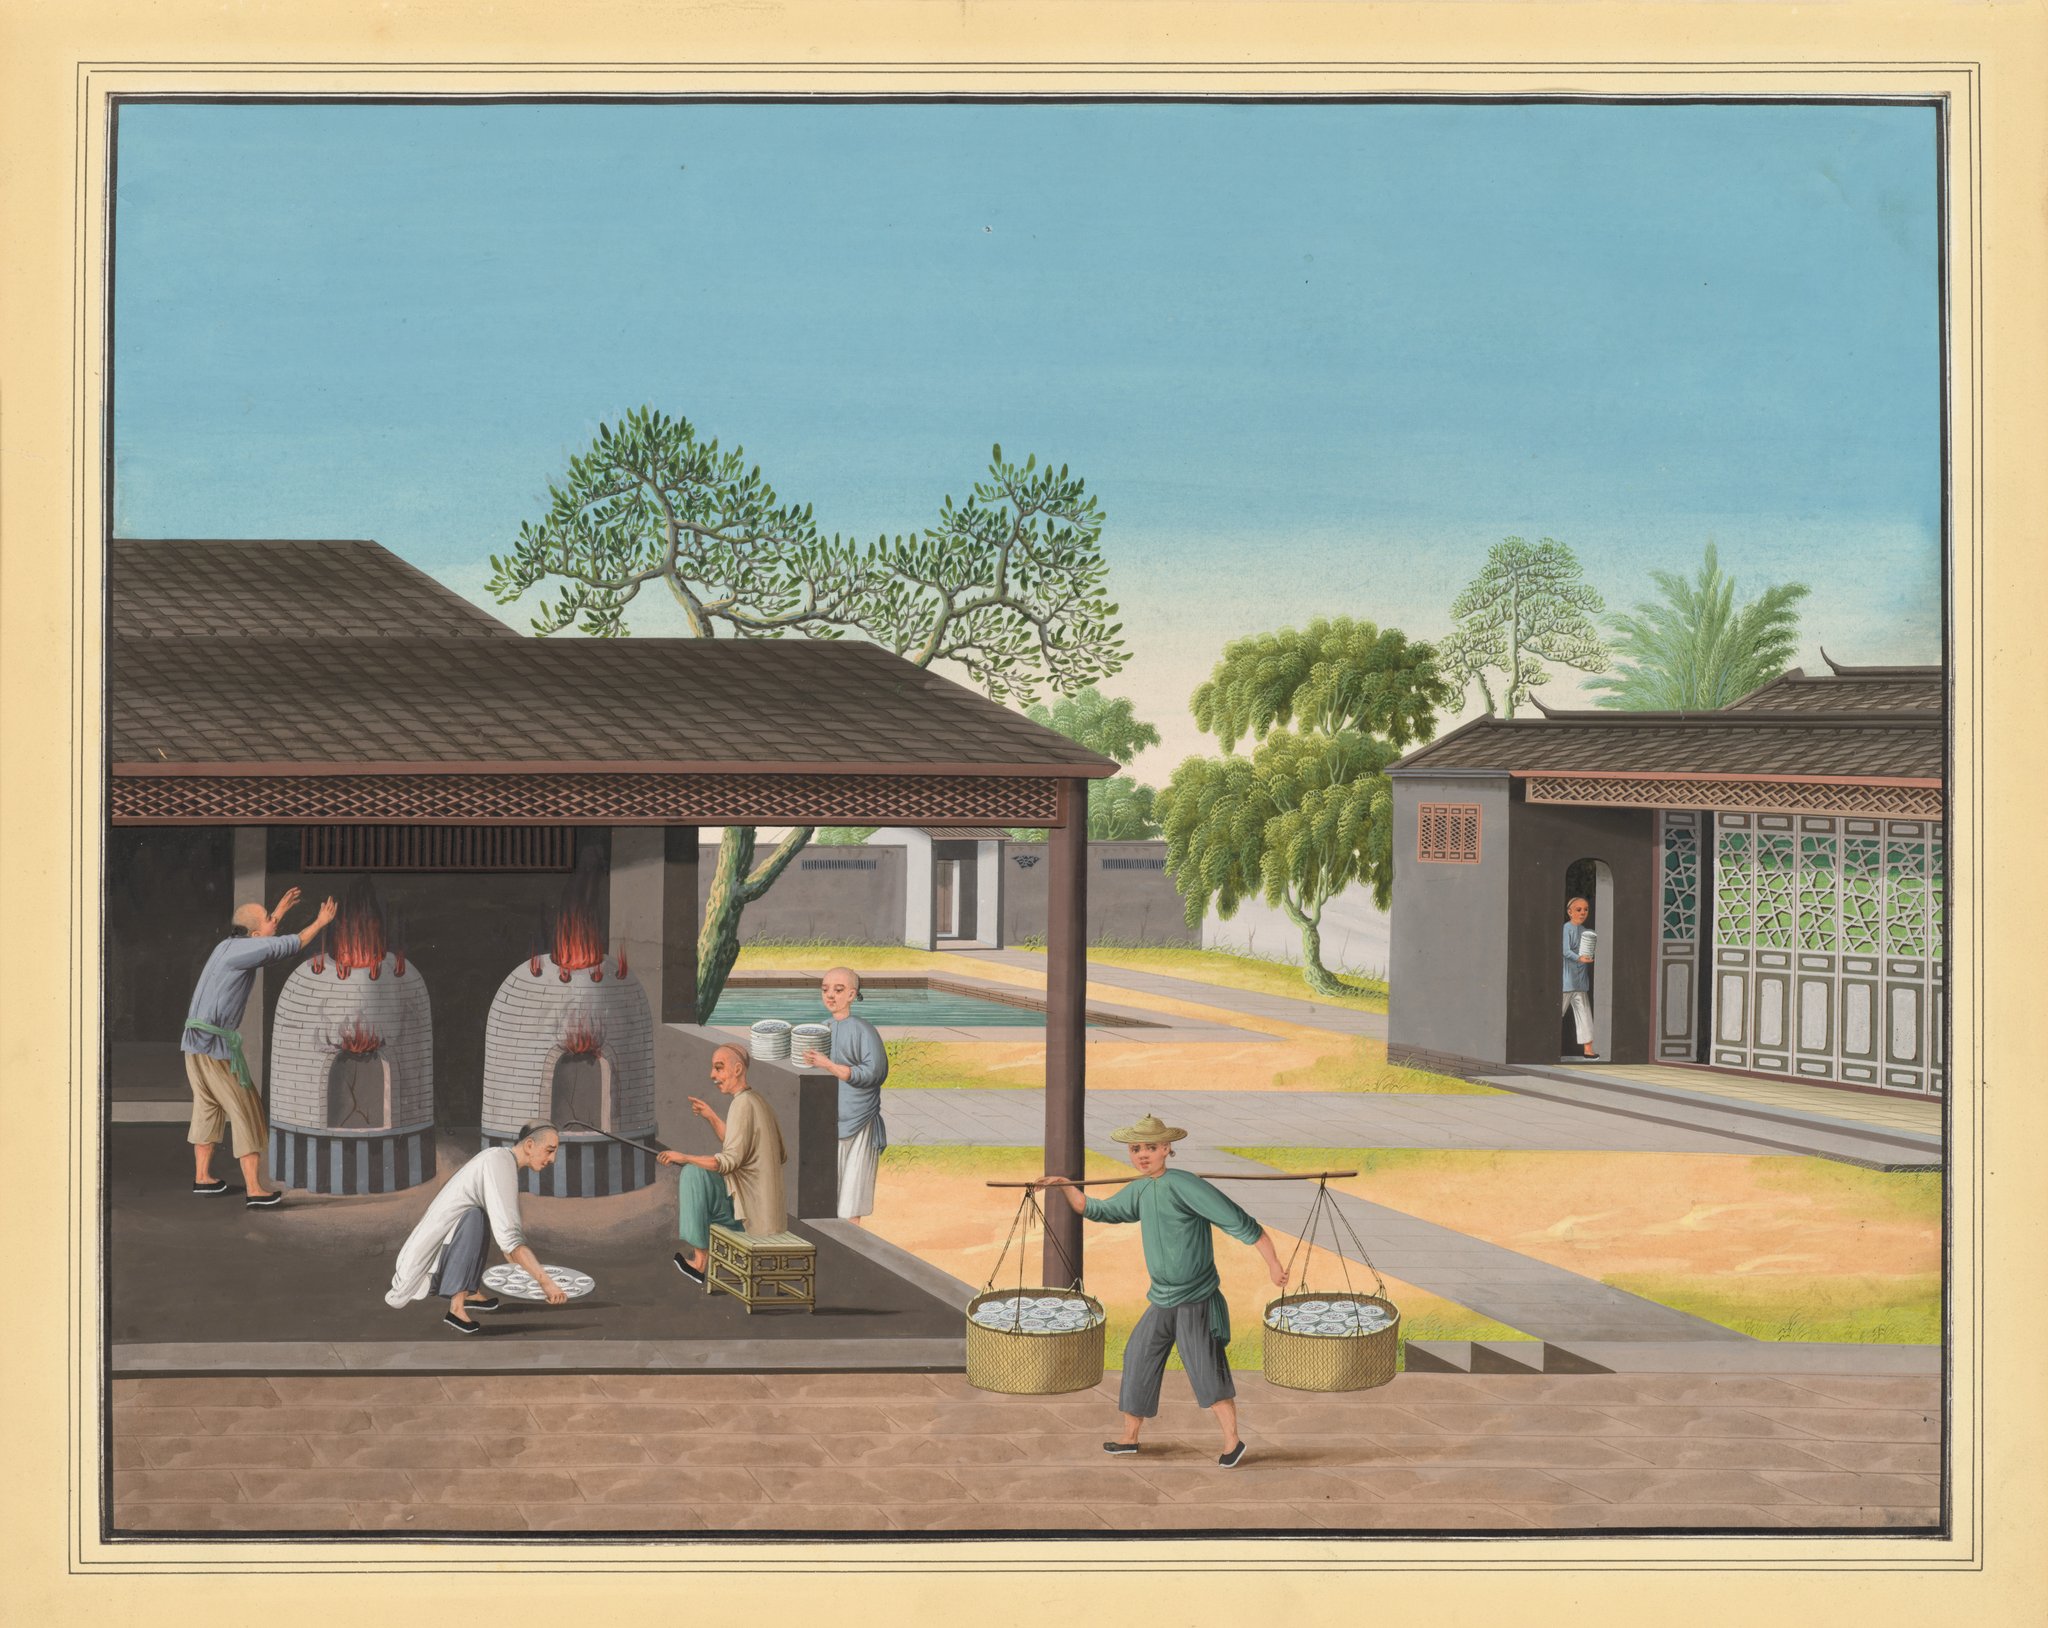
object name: painting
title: Using Muffle Stoves for the Firing of Porcelain in a Cantonese Workshop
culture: chinese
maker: unidentified artist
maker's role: artist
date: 1830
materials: paper, watercolor